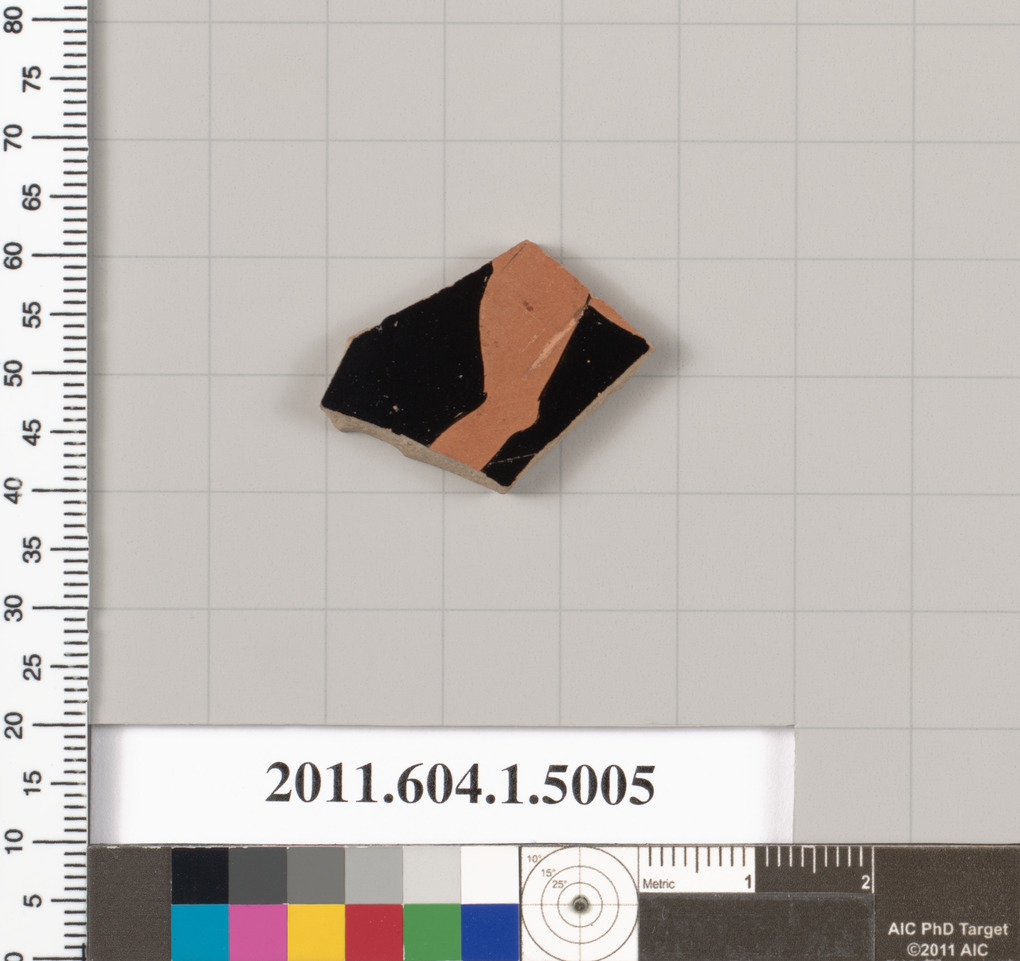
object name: kylix fragment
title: Terracotta fragment of a kylix (drinking cup)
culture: greek, attic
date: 510-490 BCE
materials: terracotta